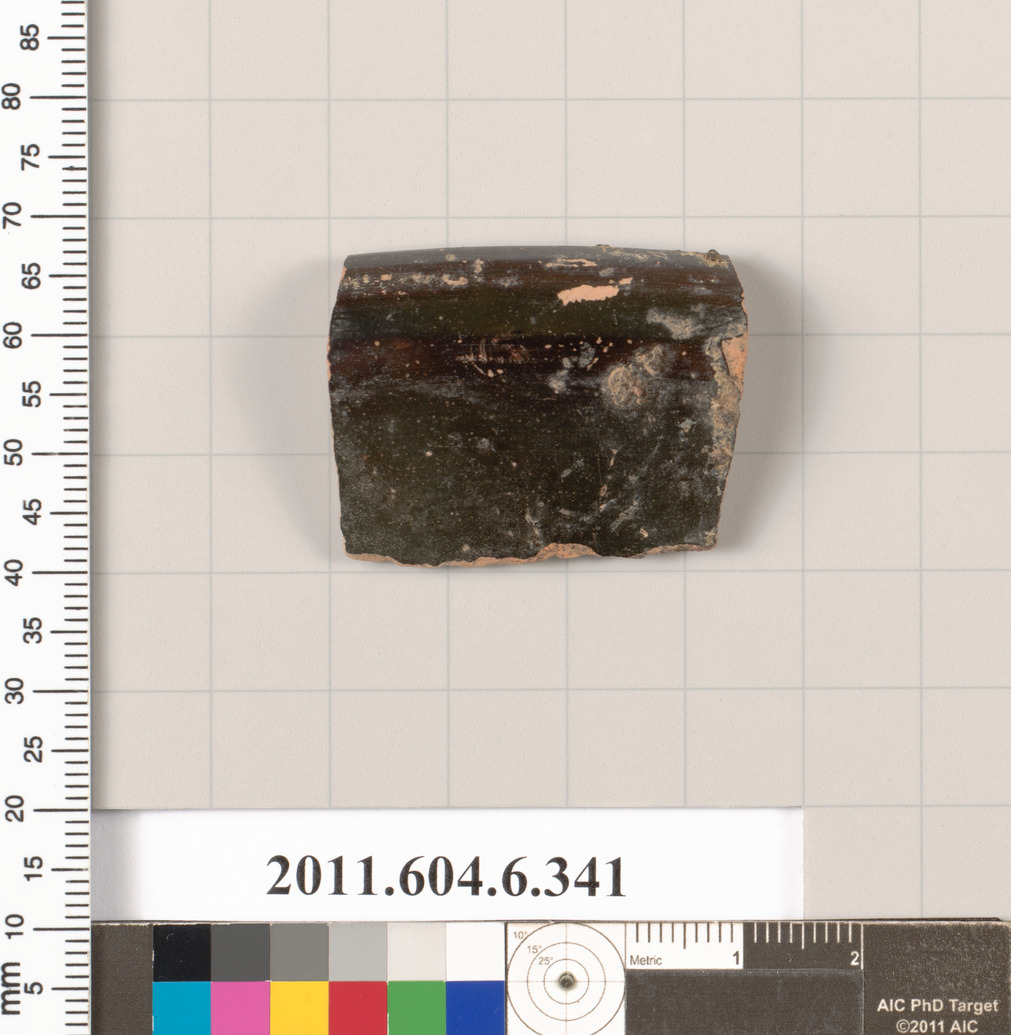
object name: fragment of a bowl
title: Terracotta rim fragment of a bowl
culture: greek, attic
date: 600-401 BCE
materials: terracotta